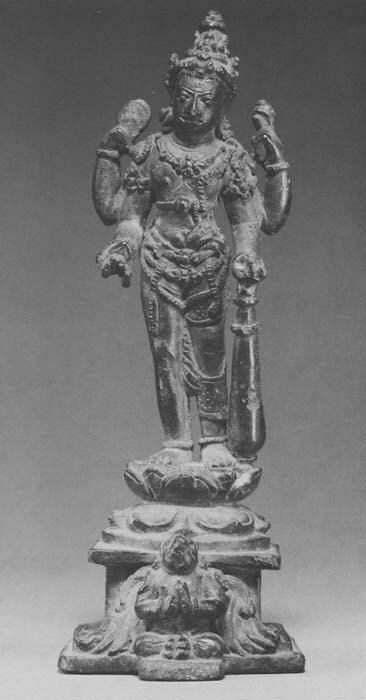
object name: figure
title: Standing Four-Armed Vishnu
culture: indonesian, javanese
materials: bronze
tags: weapons,vishnu,hinduism